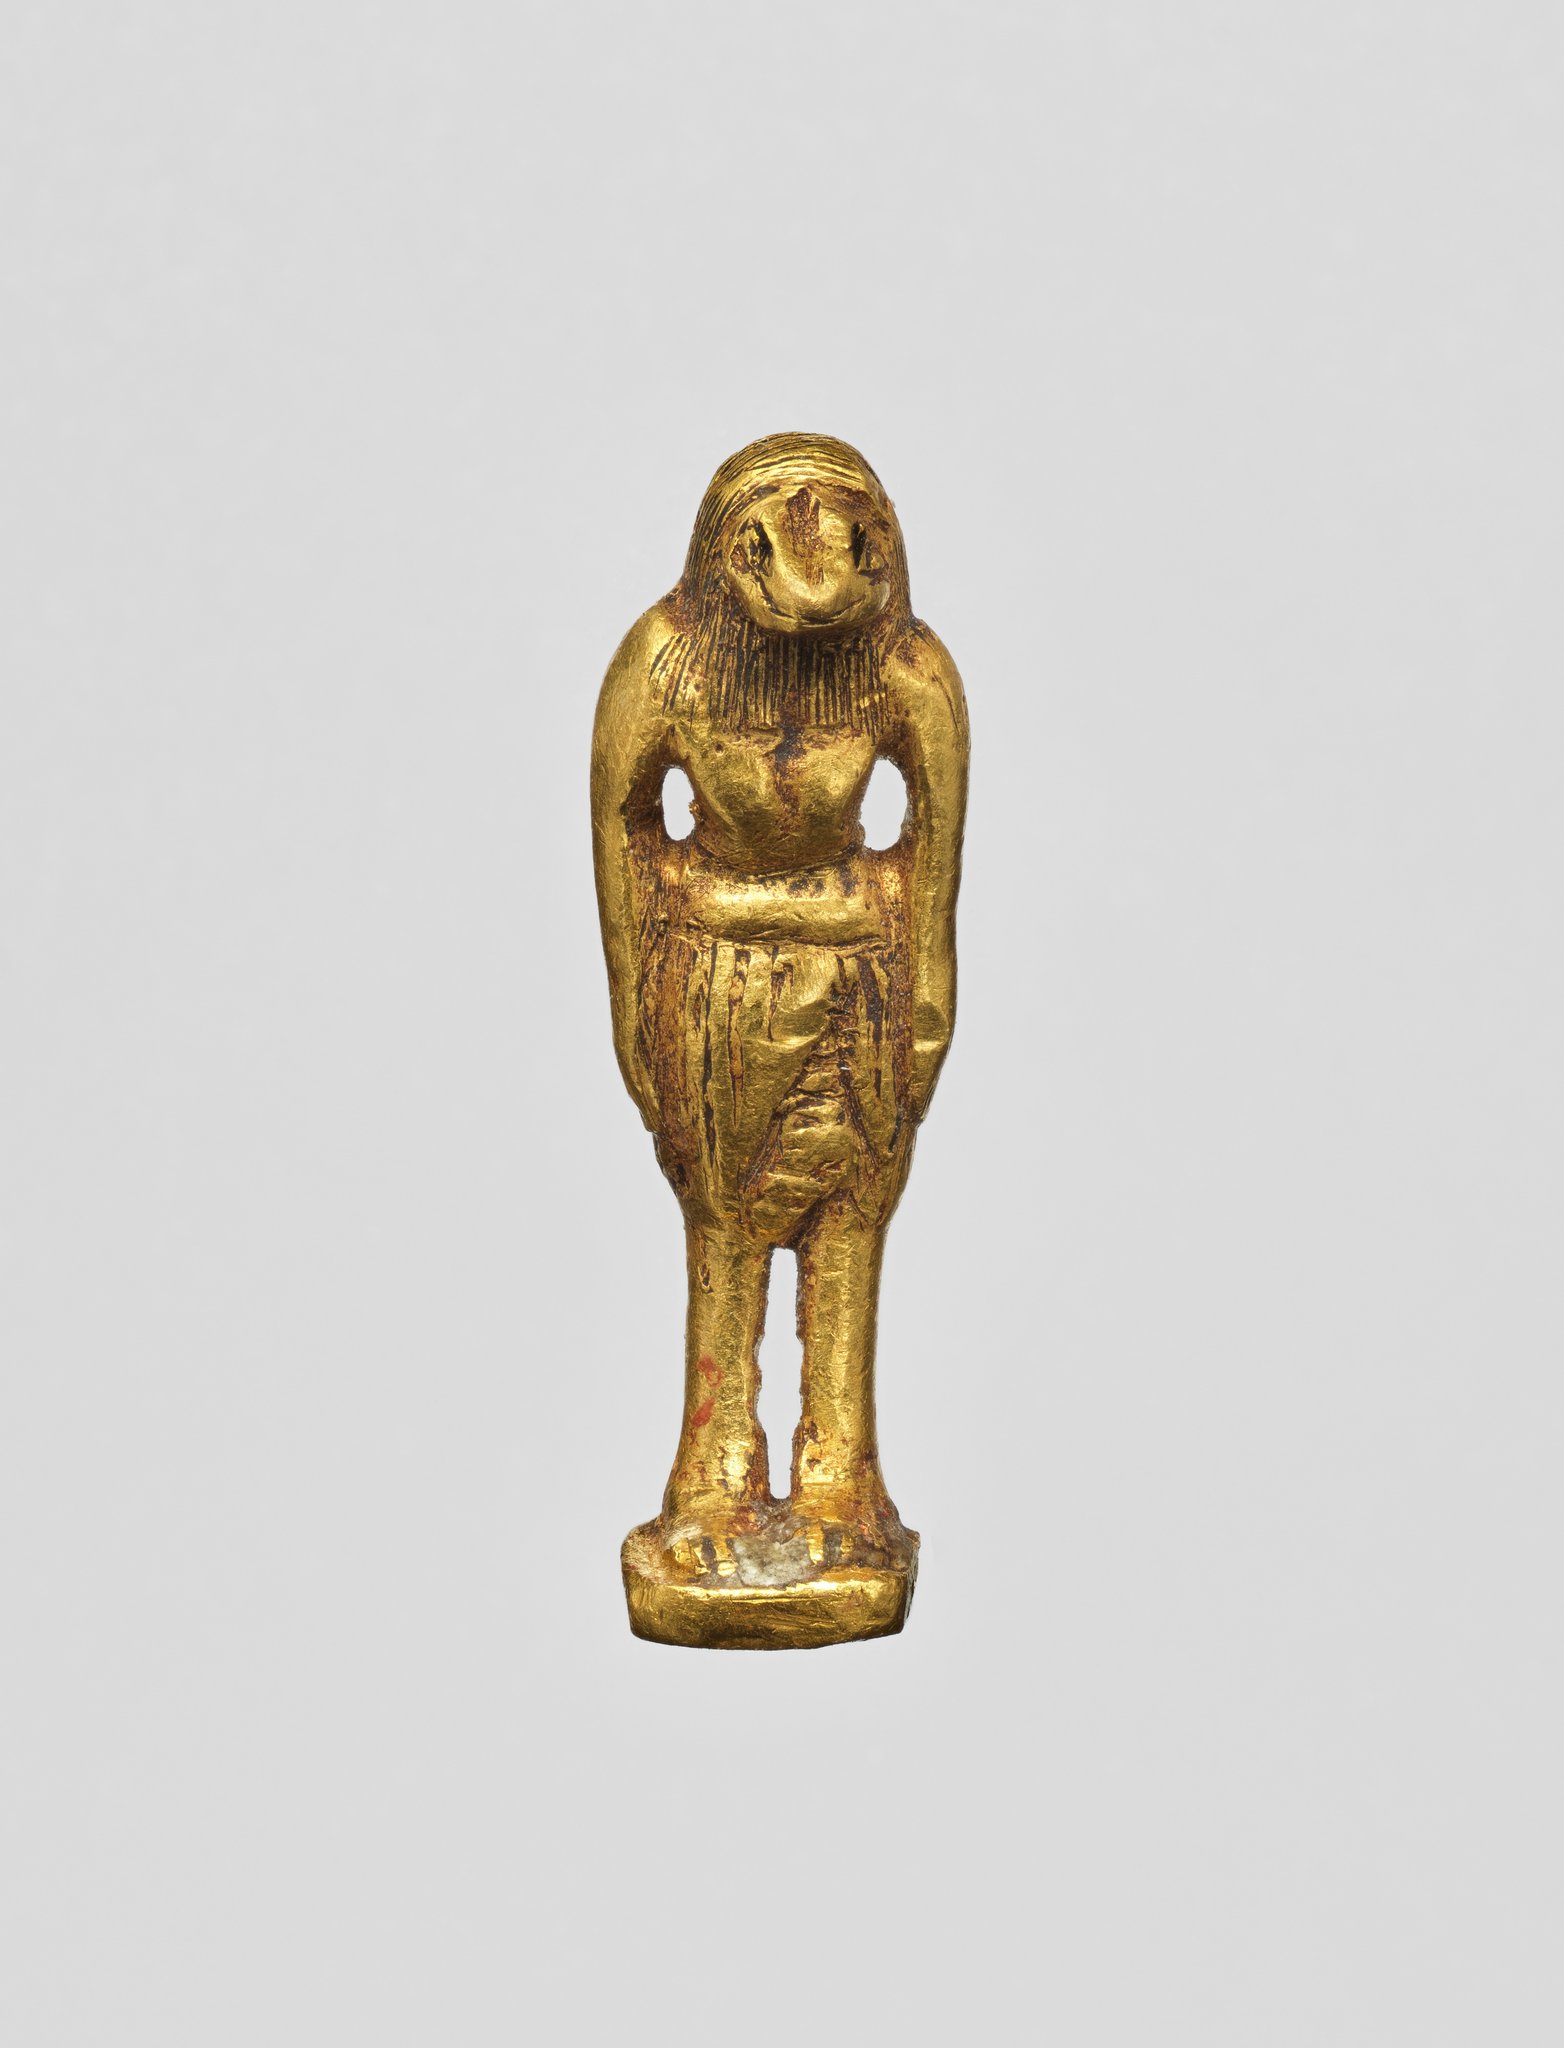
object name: amulet pendant, genius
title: Amulet pendant, genii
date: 332-330 BCE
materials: gold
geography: egypt